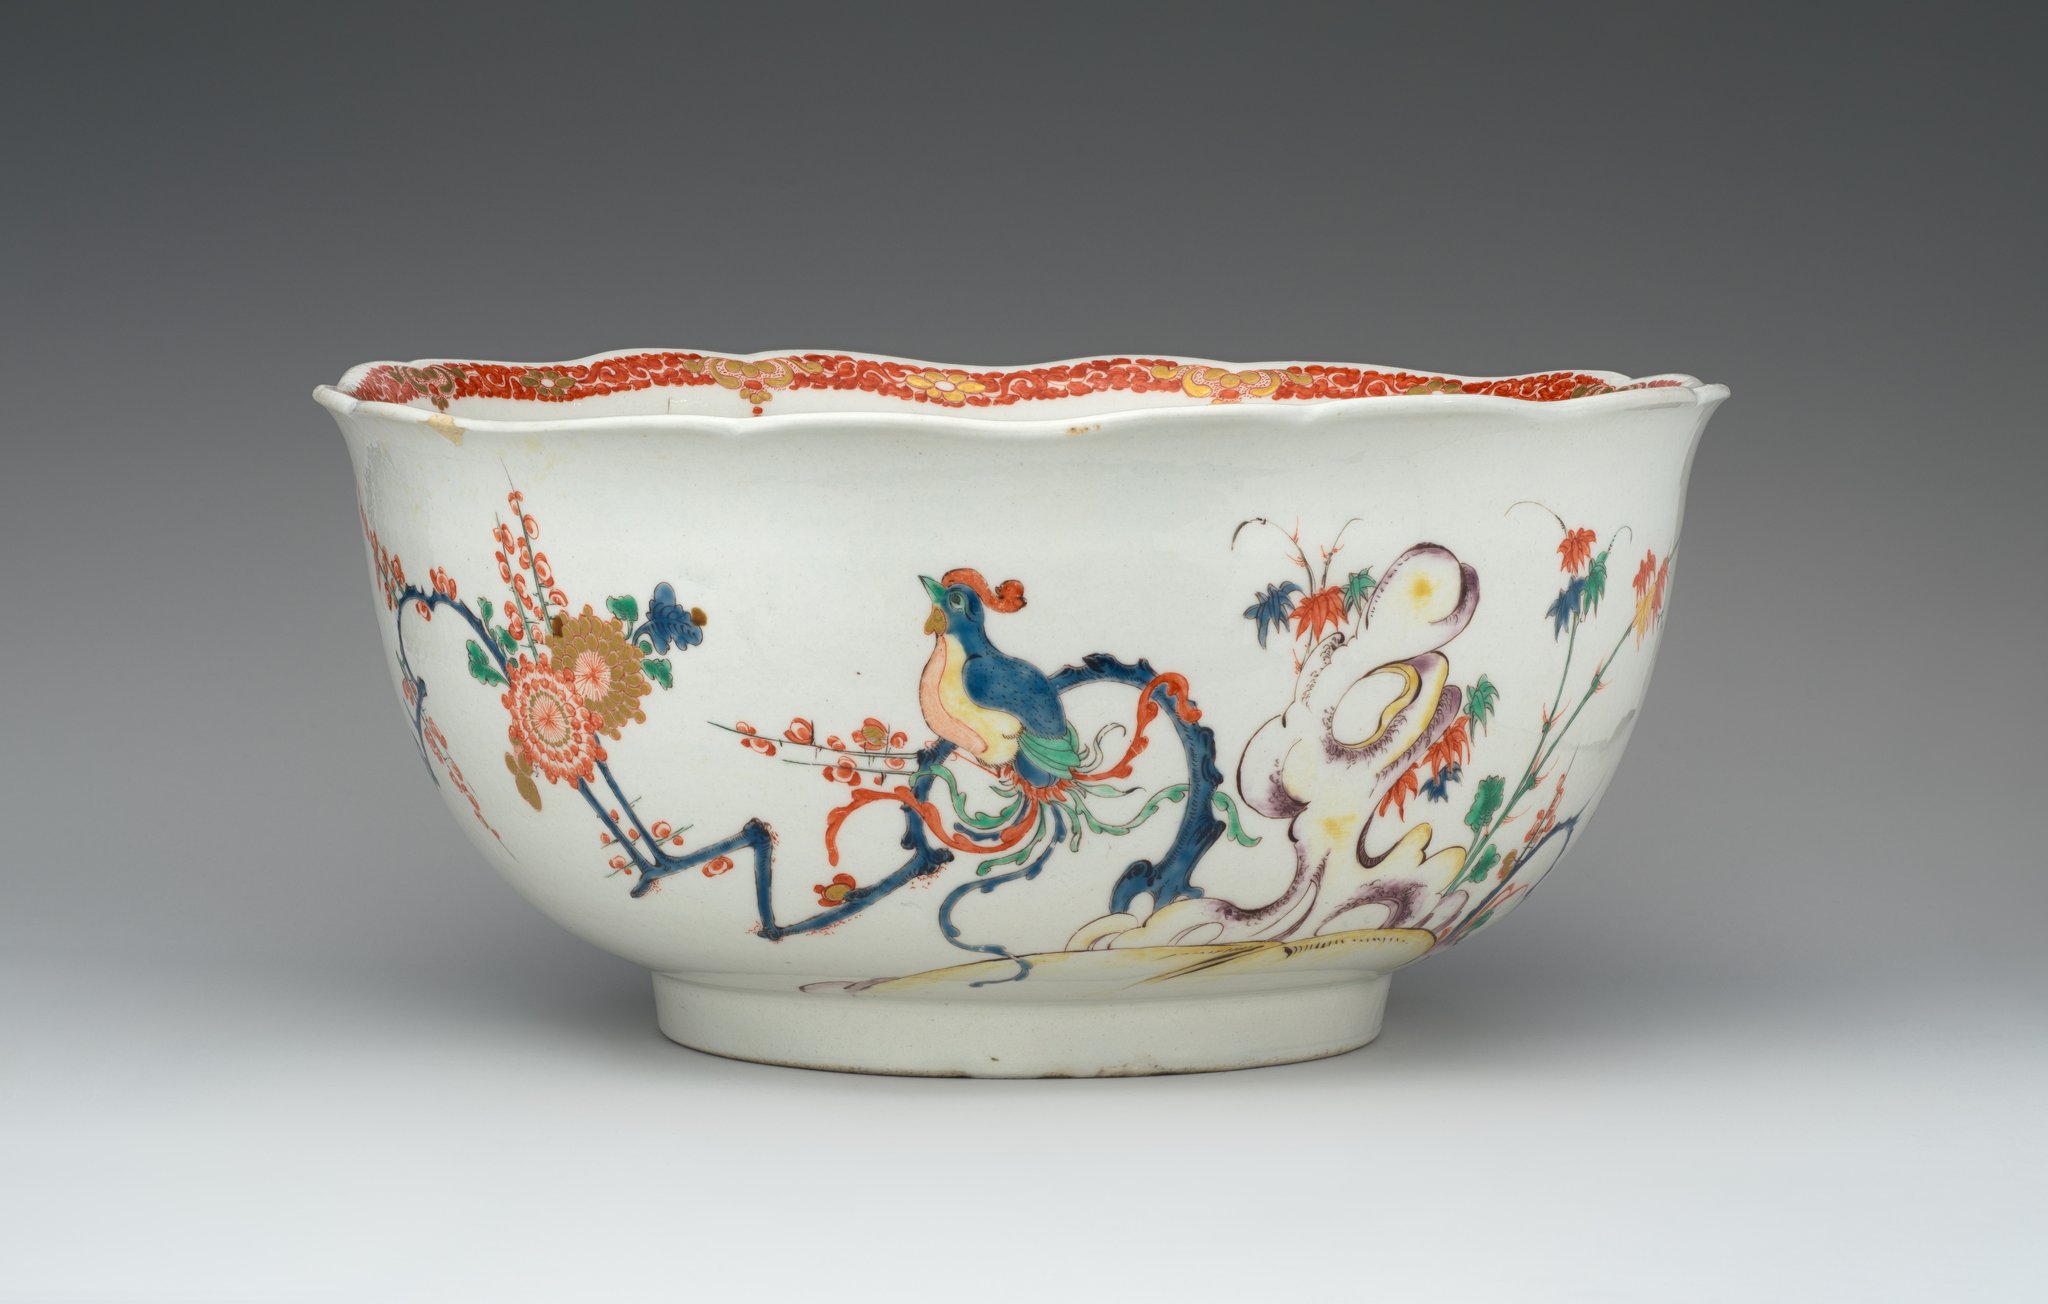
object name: bowl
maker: bow porcelain factory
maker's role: factory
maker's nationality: british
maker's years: 1747-1776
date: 1755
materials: soft paste porcelain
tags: birds